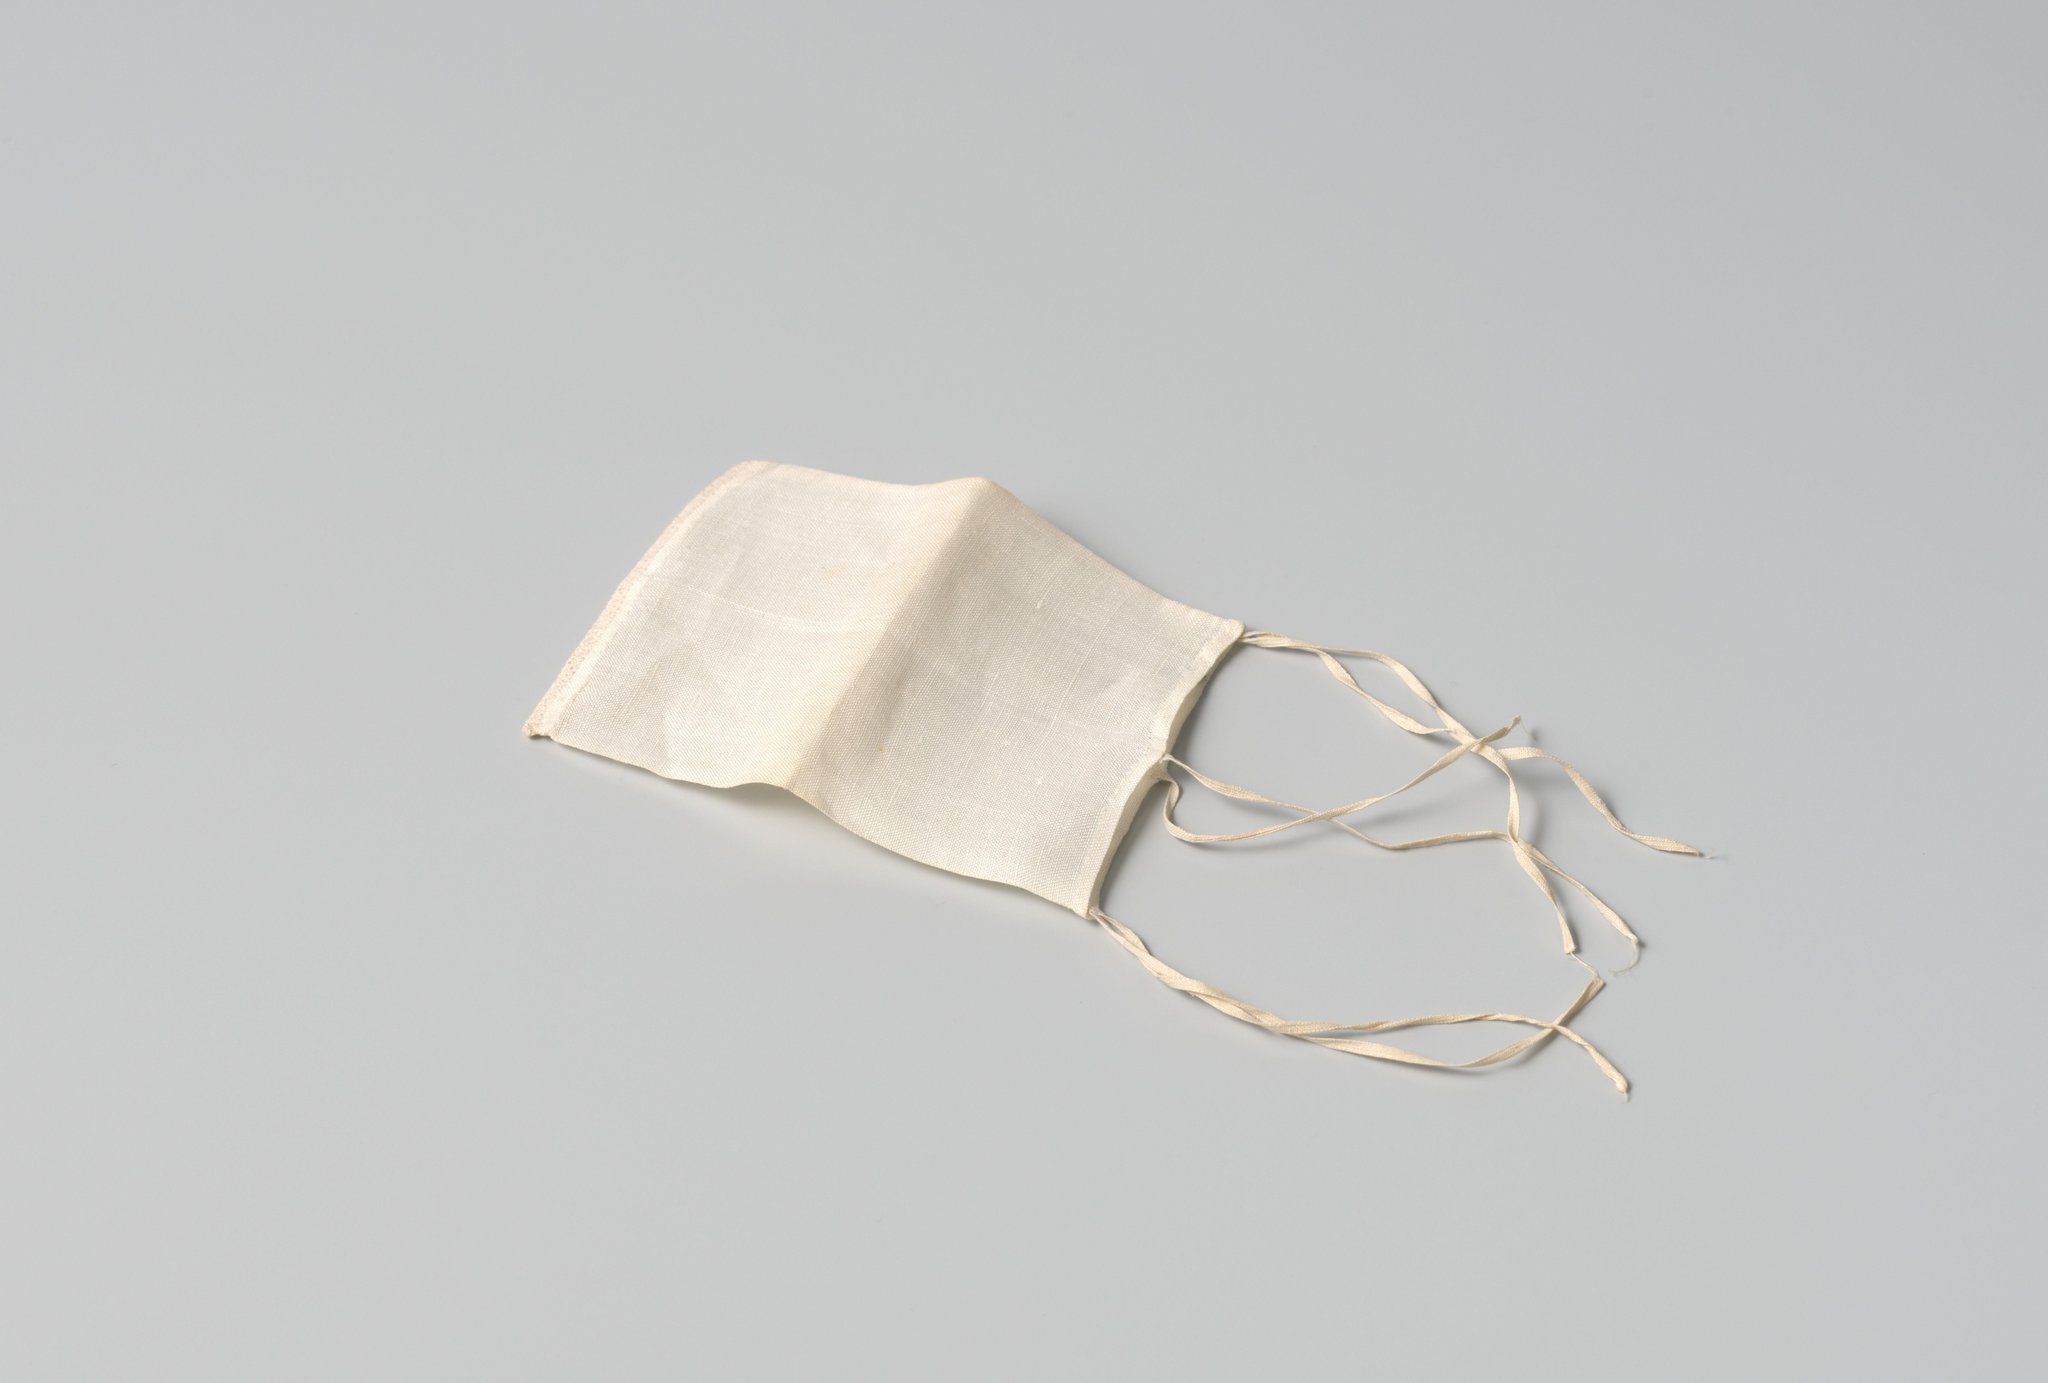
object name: sloop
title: Sloop van wit linnen, met tussenzetsel van kloskant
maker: Anonymous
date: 1676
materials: linen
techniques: lace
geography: amsterdam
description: Sloop van zeer fijn wit linnen (batist), aan één zijde met tussenzetsel van kloskant aan zoom. Sluiting door middel van twee keer drie sluitbanden, vastgezet op de zoom.